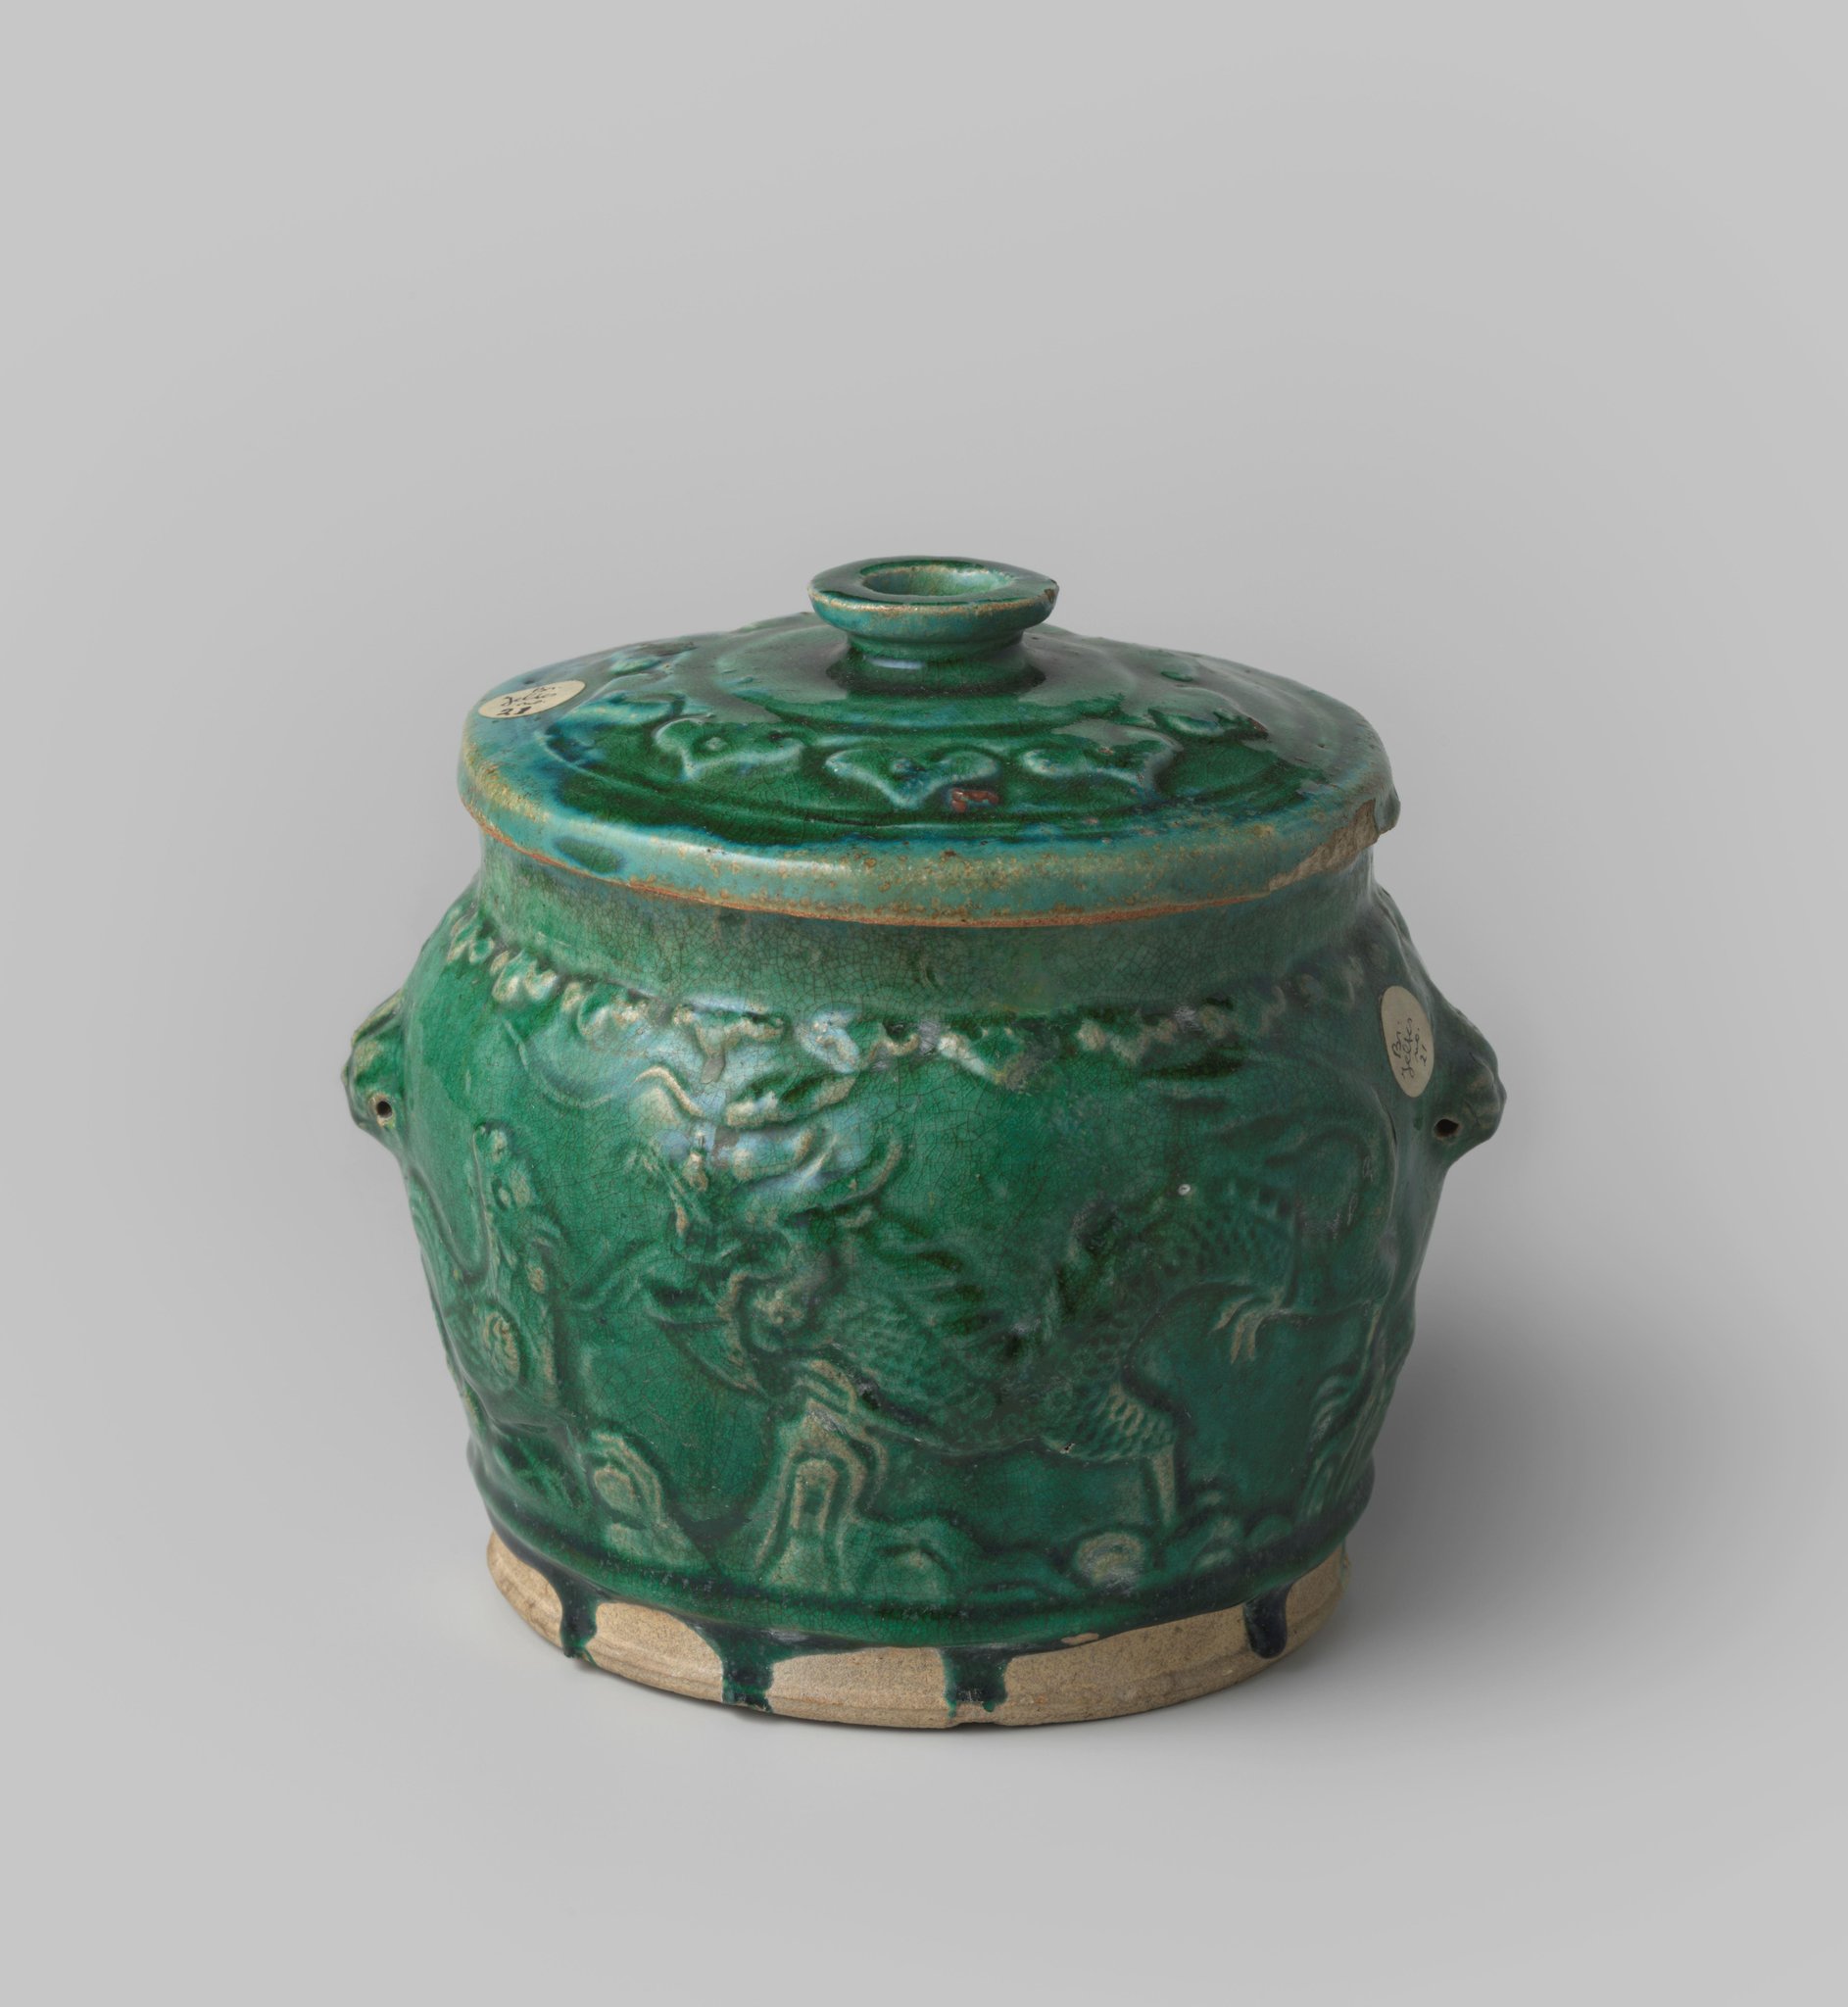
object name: covered jar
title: Deksel van pot, groen geglazuurd met reliëf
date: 1850-1950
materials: earthenware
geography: china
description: Deksel van pot, van aardewerk, groen geglazuurd en met klaverdriebladeren reliëf versierd.